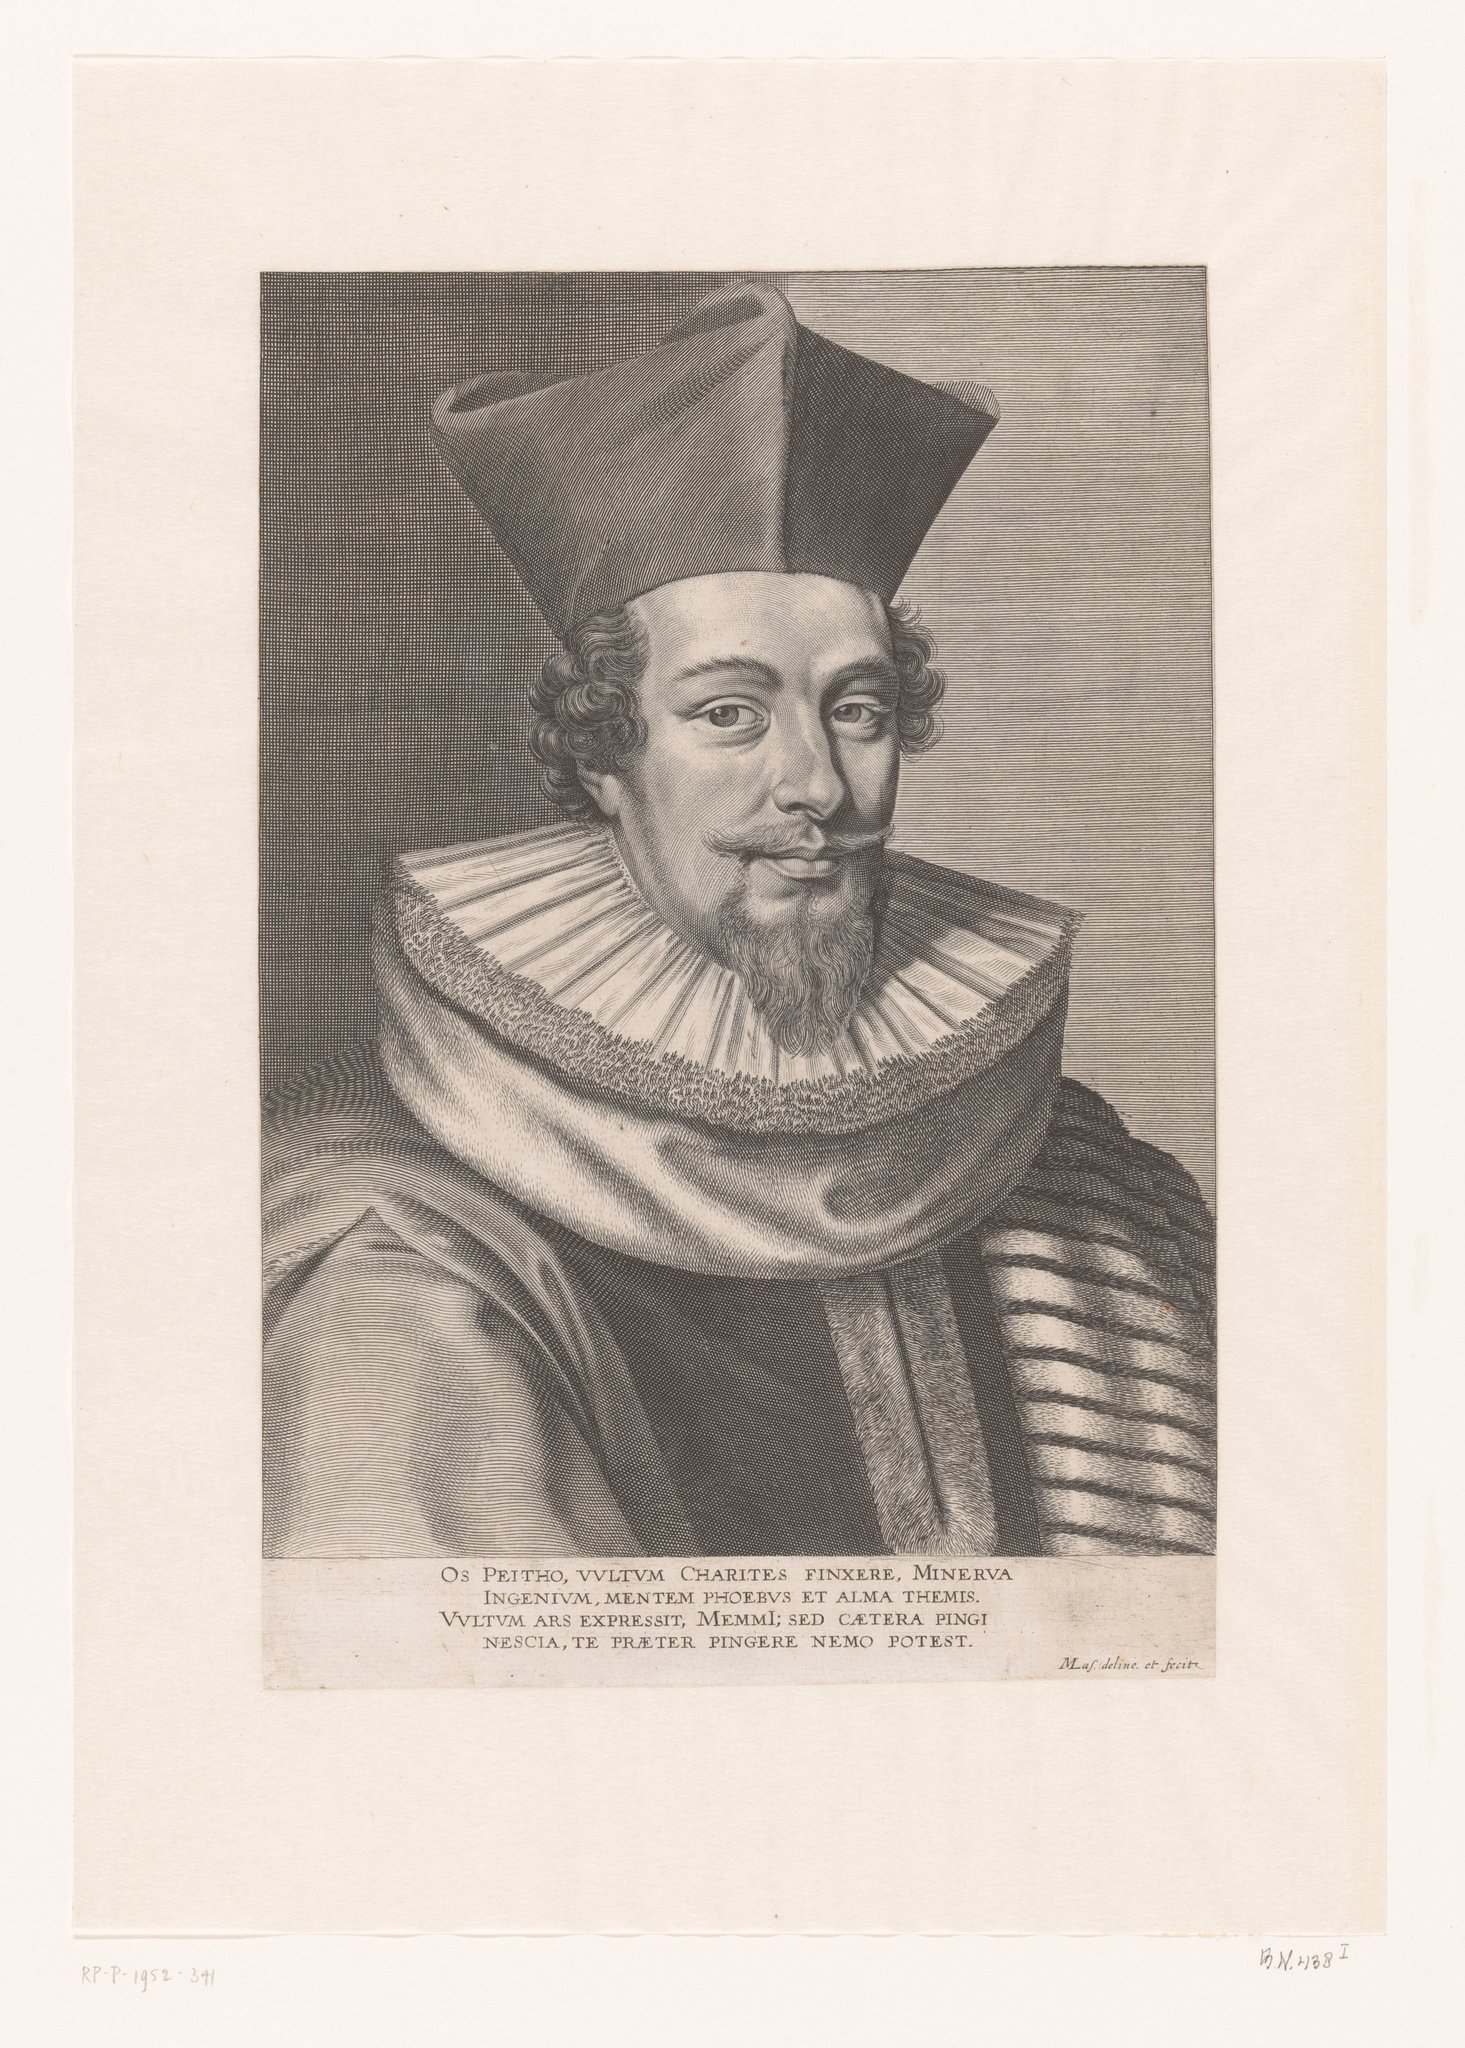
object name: print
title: Portret van Henri de Mesmes heer van Roissy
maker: michel lasne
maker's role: print maker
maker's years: 1590-1667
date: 1600-1667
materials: paper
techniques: engraving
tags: historical persons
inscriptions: collector's mark: Lugt 2228